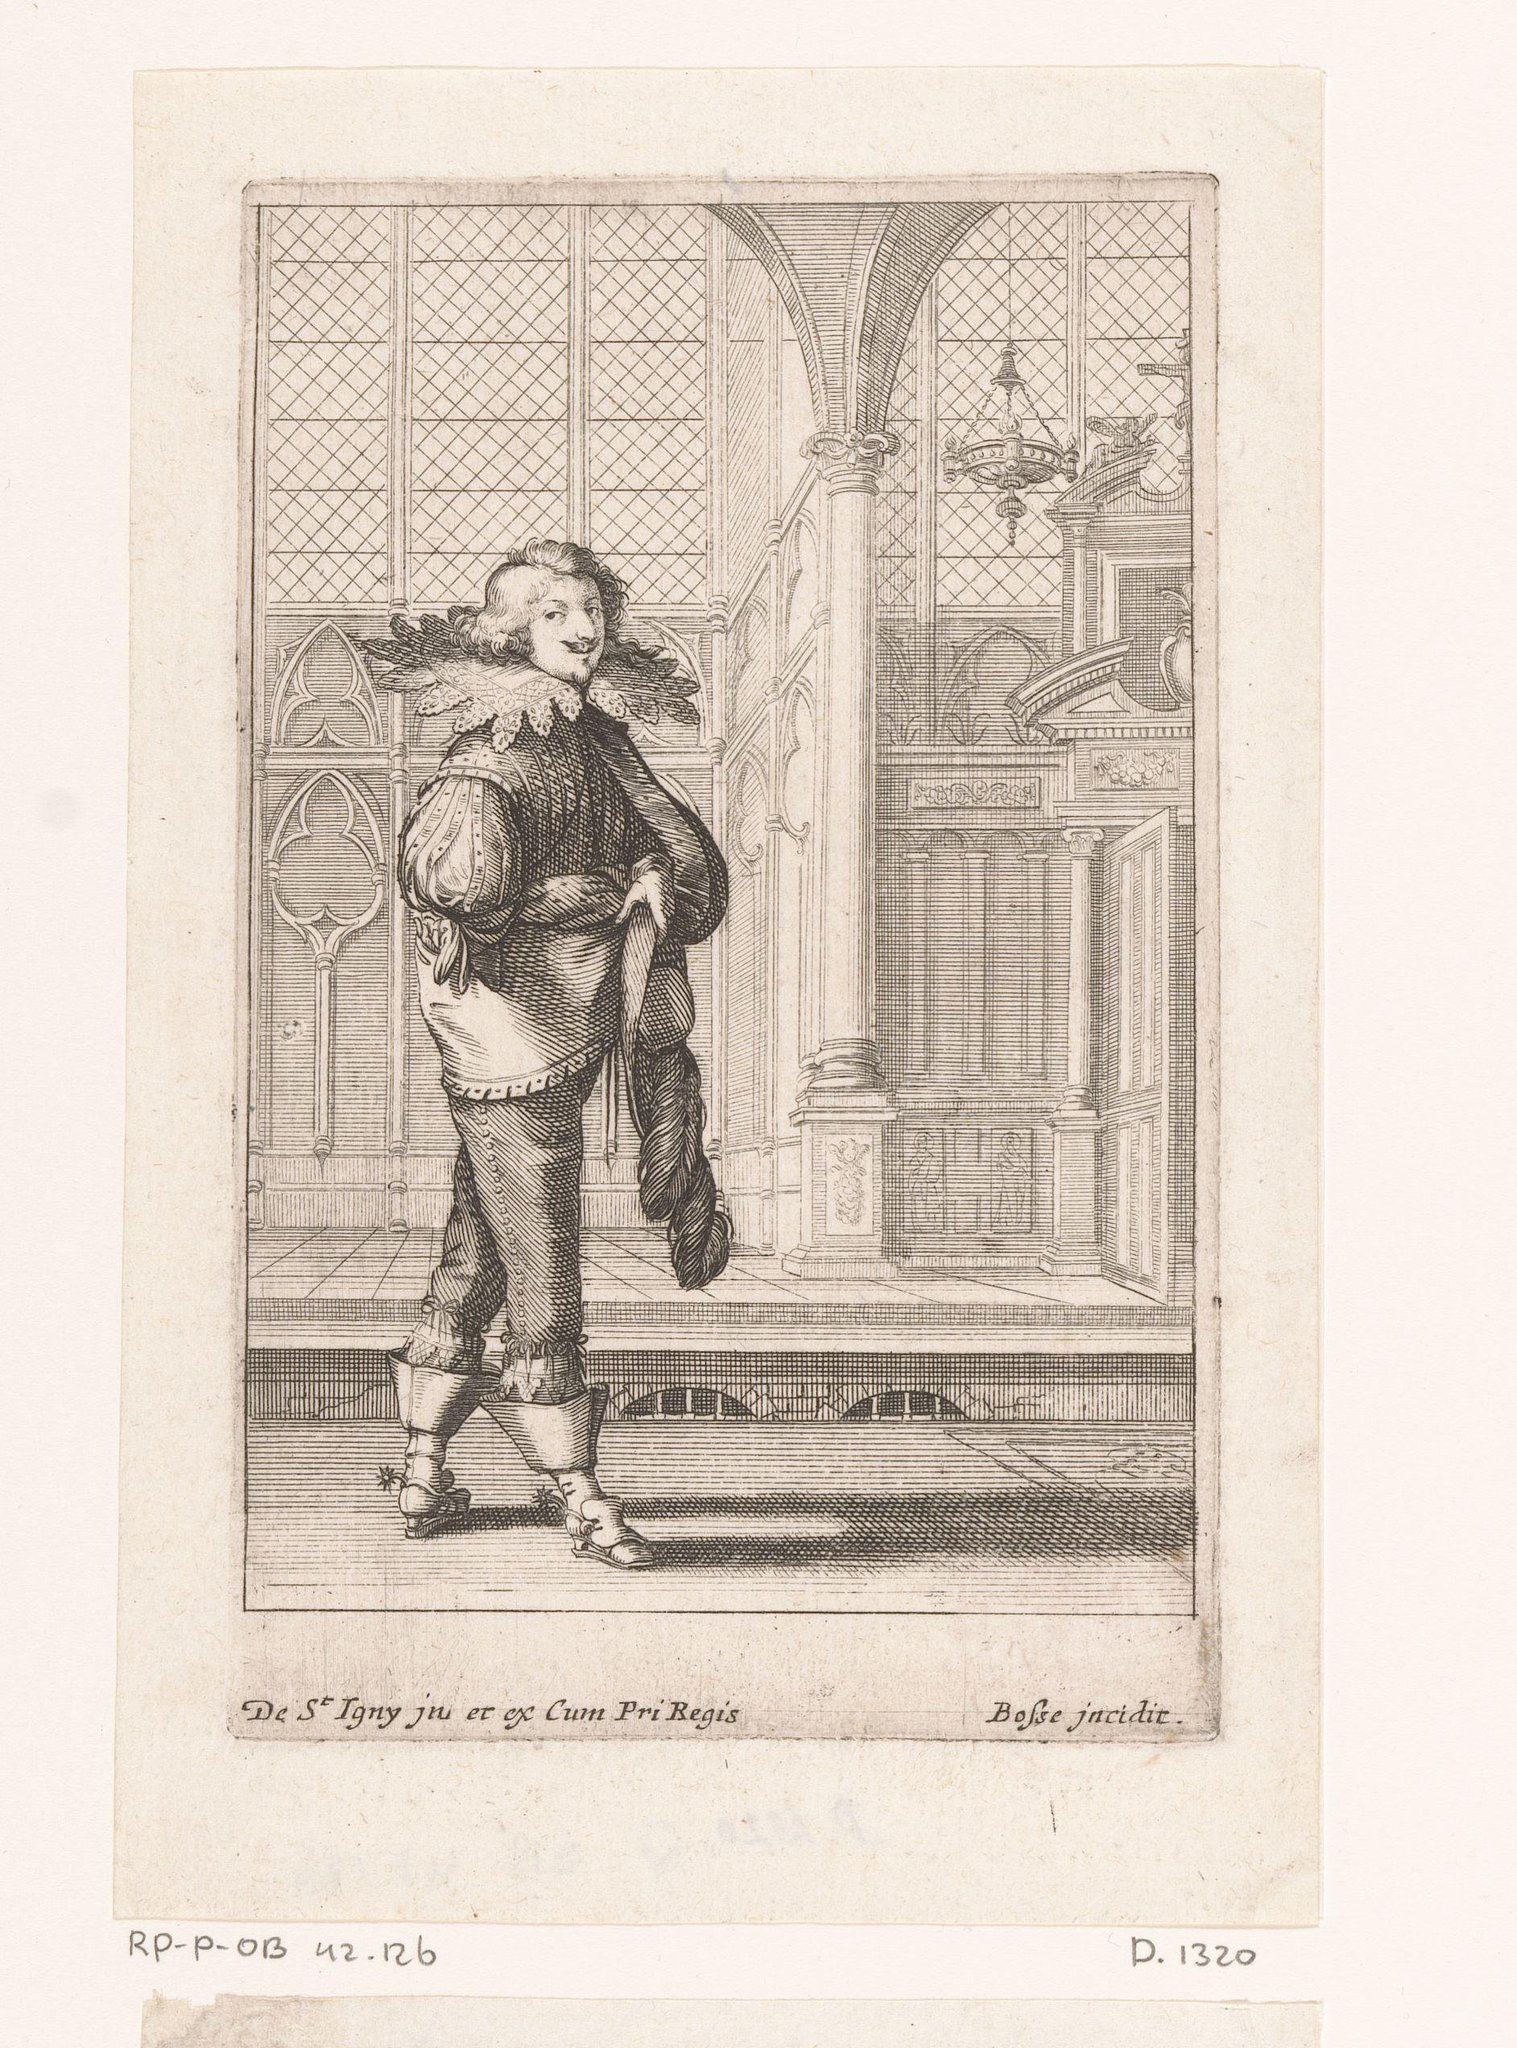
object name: costume print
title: La Noblesse Française à l’église (The French Nobility at Church)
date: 1628-1629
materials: paper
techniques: engraving, etching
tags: head-gear: hat (+ men's clothes), styles of hairdress, europeans (with name), interior of church, clothes, costume (+ men's clothes), shoes, sandals, neck-gear: collar (+ men's clothes), trousers, breeches, etc. (breeches) (+ men's clothes), clothing for the upper part of the body (doublet) (+ men's clothes), boots (+ men's clothes), head-gear: hat (+ feathers used for clothes)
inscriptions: collector's mark: Lugt 240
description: Bosse portrayed the Gothic churches of Paris as sites of piety and fashionability. While praying or merely strutting through the centuries-old architecture, the churchgoers in these prints sport the latest styles. For example, in the few years since Callot’s series (adjacent), an ornate and expensive form of lace cutwork – reticella – had become a popular form of decoration for collars and cuffs.